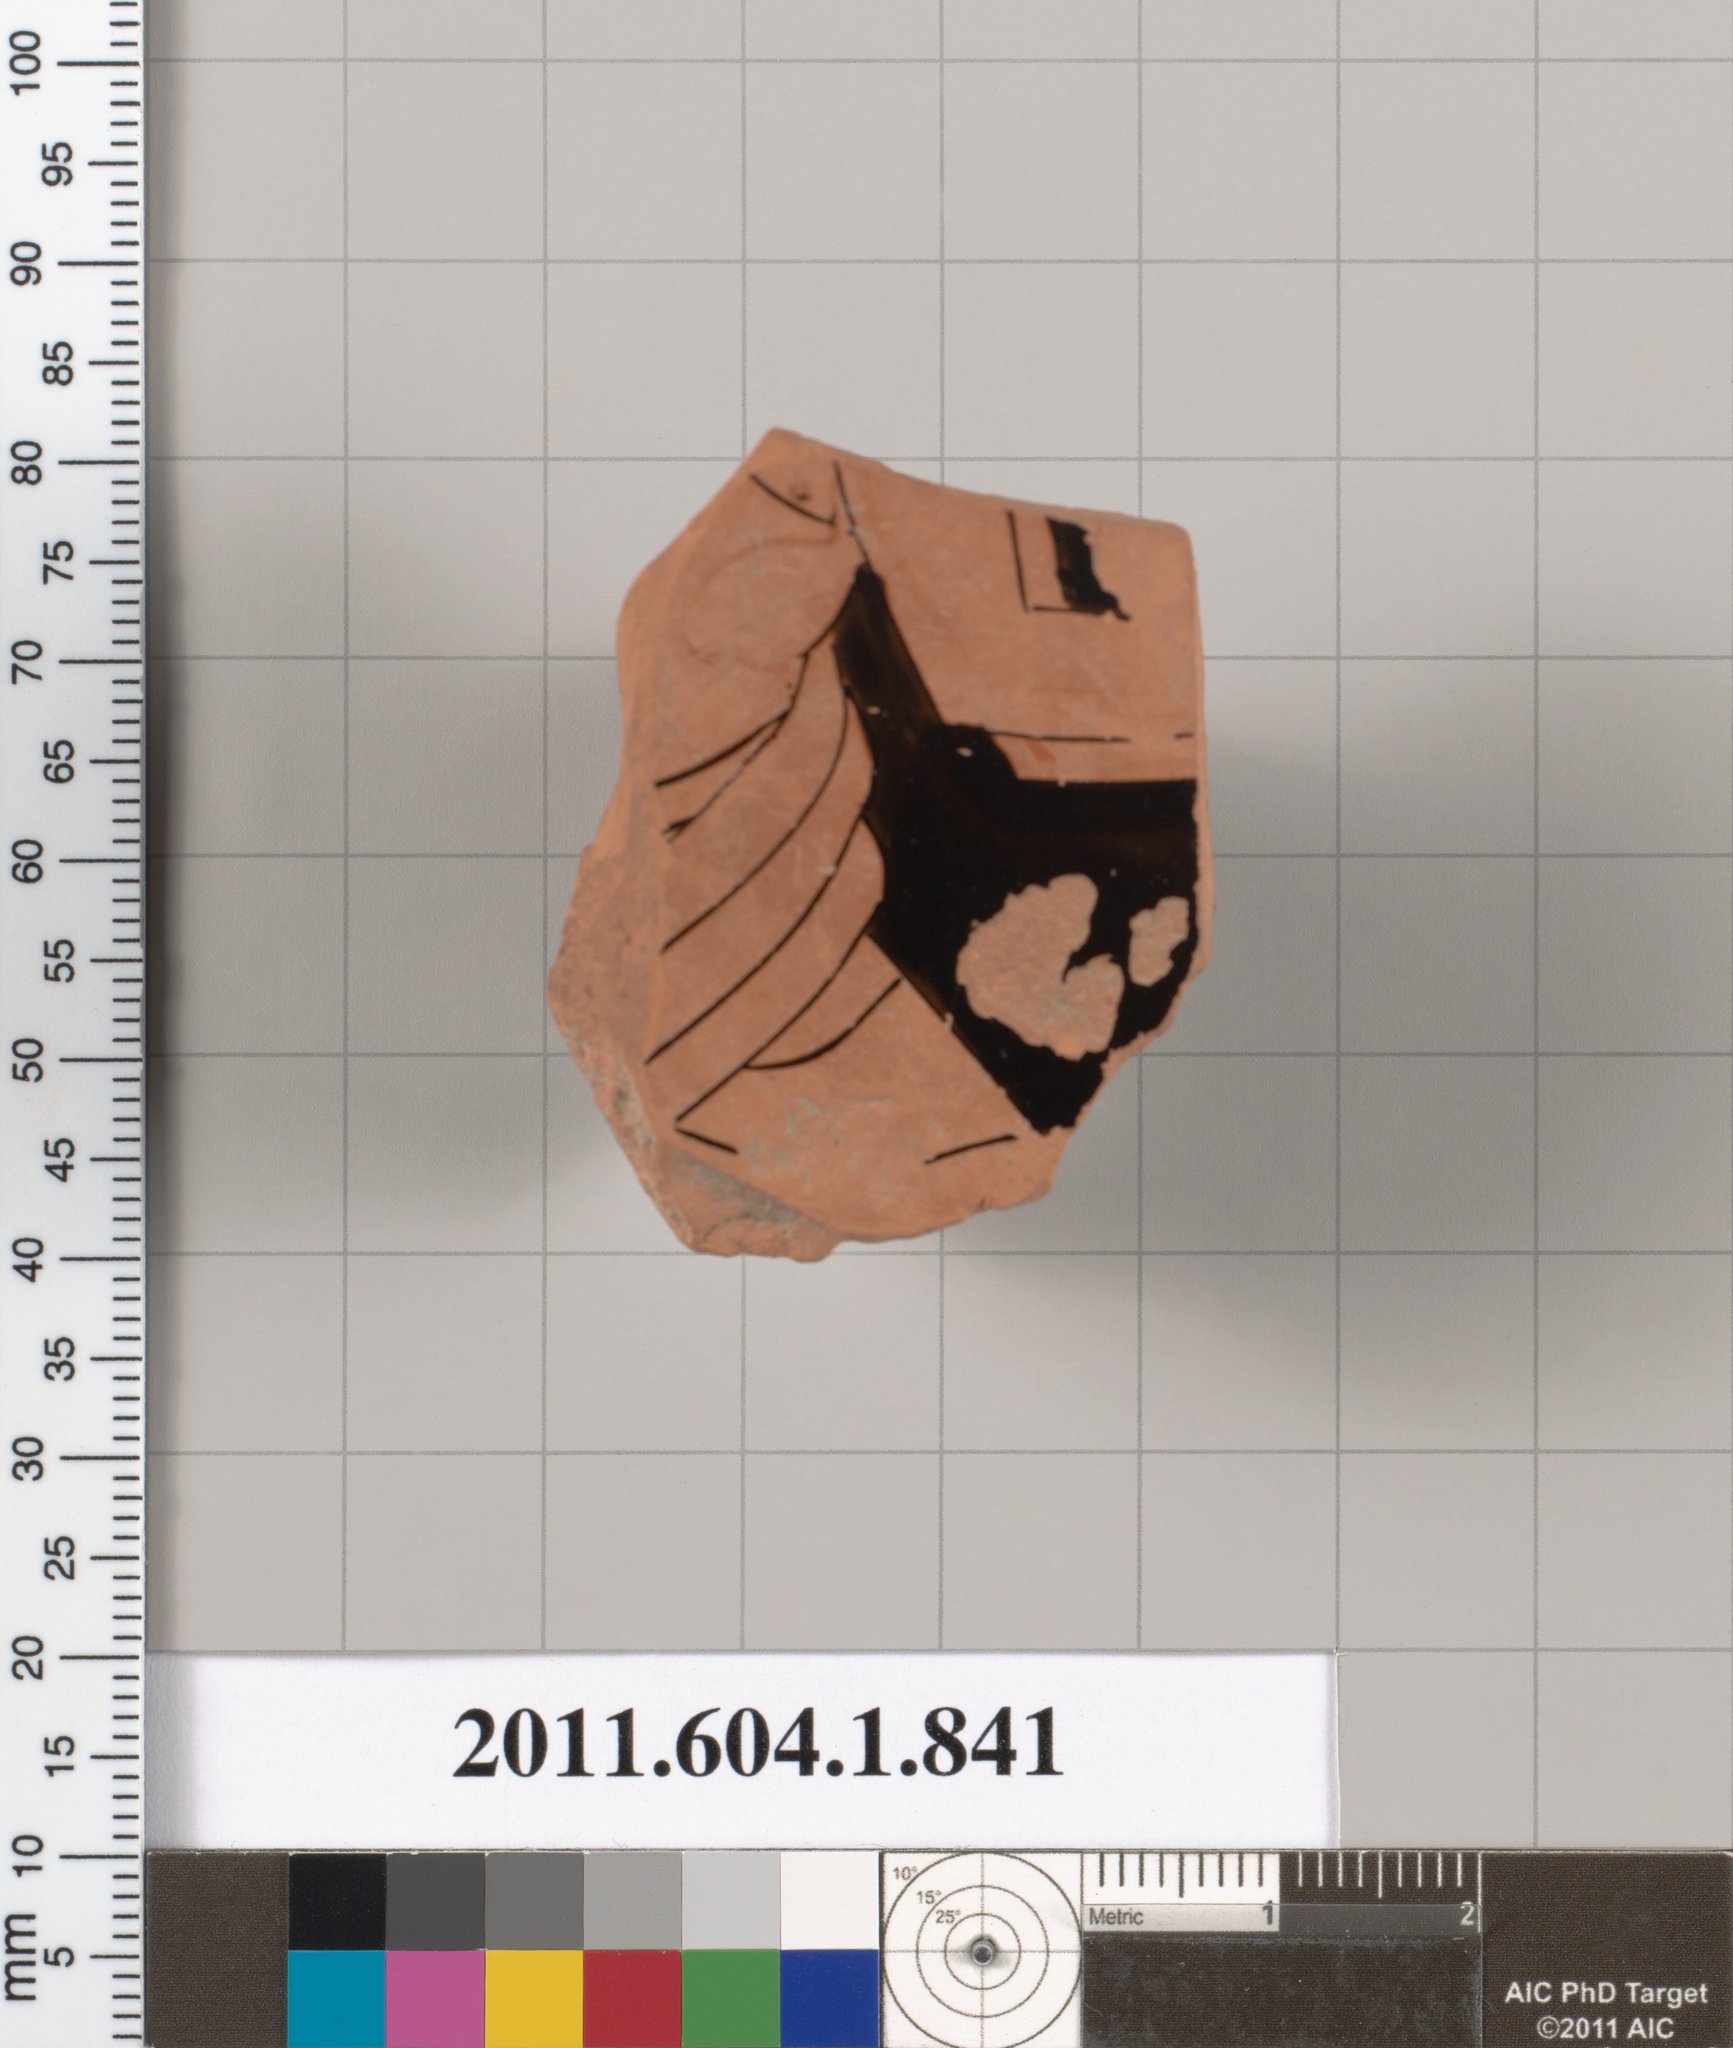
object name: kylix fragment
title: Terracotta fragment of a kylix (drinking cup)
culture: greek, attic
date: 480-470 BCE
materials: terracotta